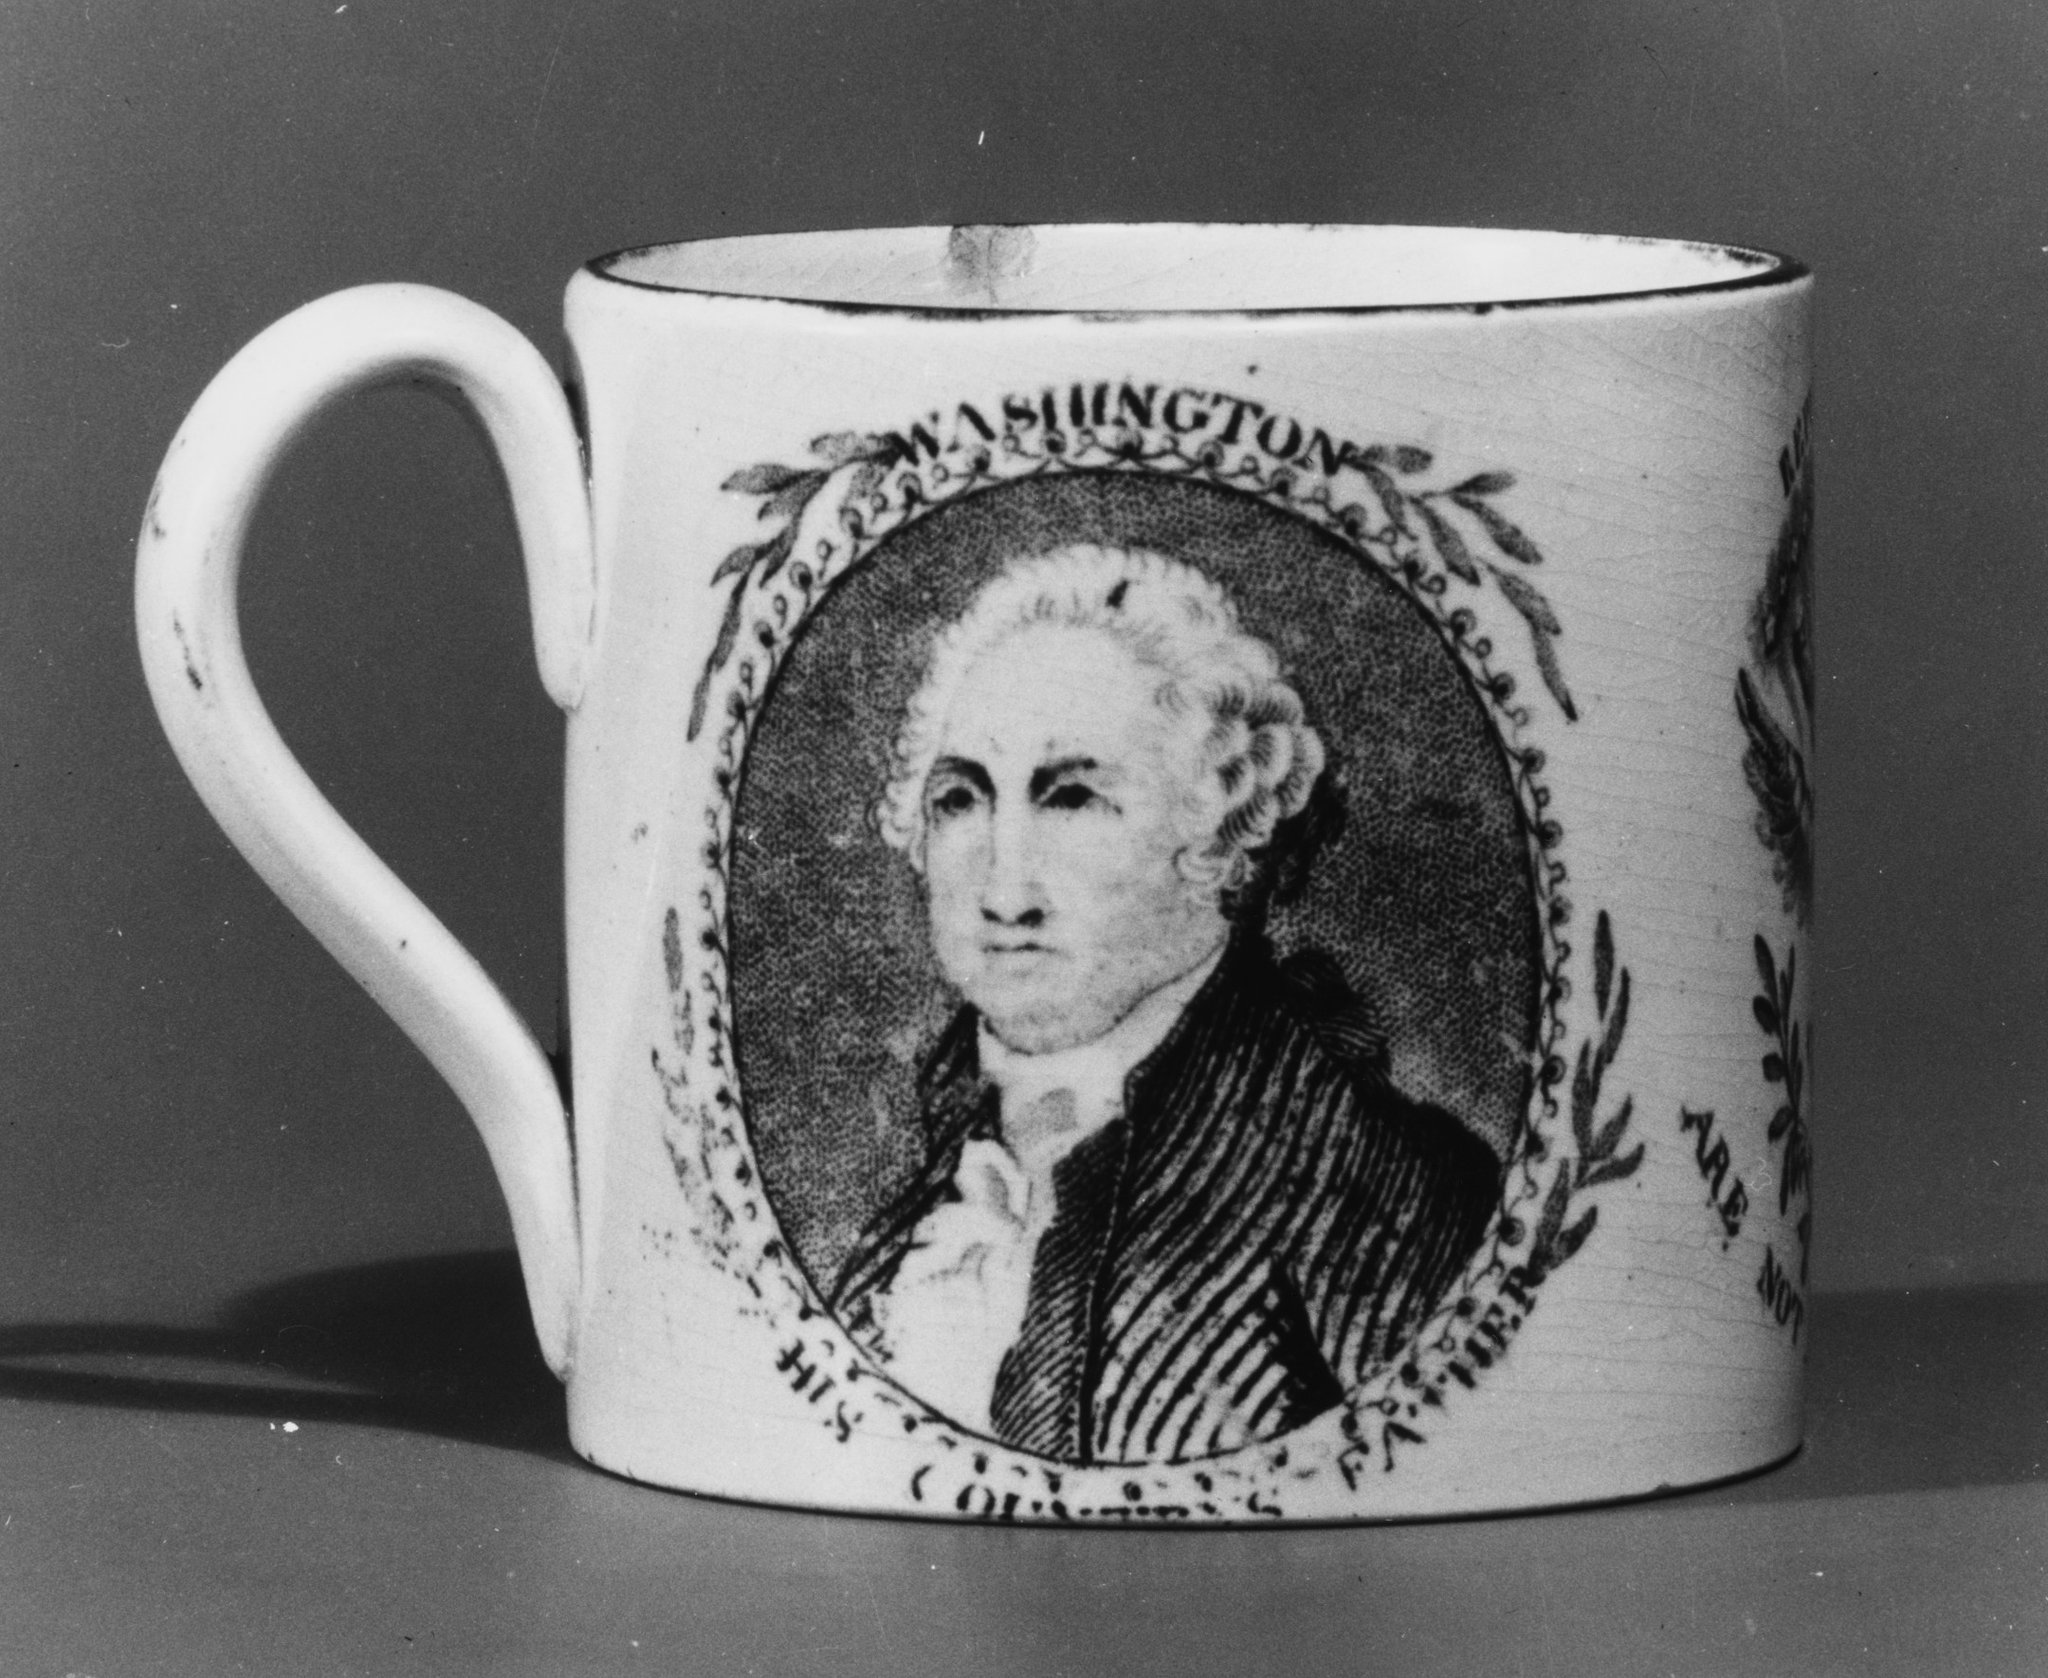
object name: mug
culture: british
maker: ralph hall & son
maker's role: maker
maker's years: 1836-1841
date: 1836-1841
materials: earthenware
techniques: transfer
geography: england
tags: george washington,portraits